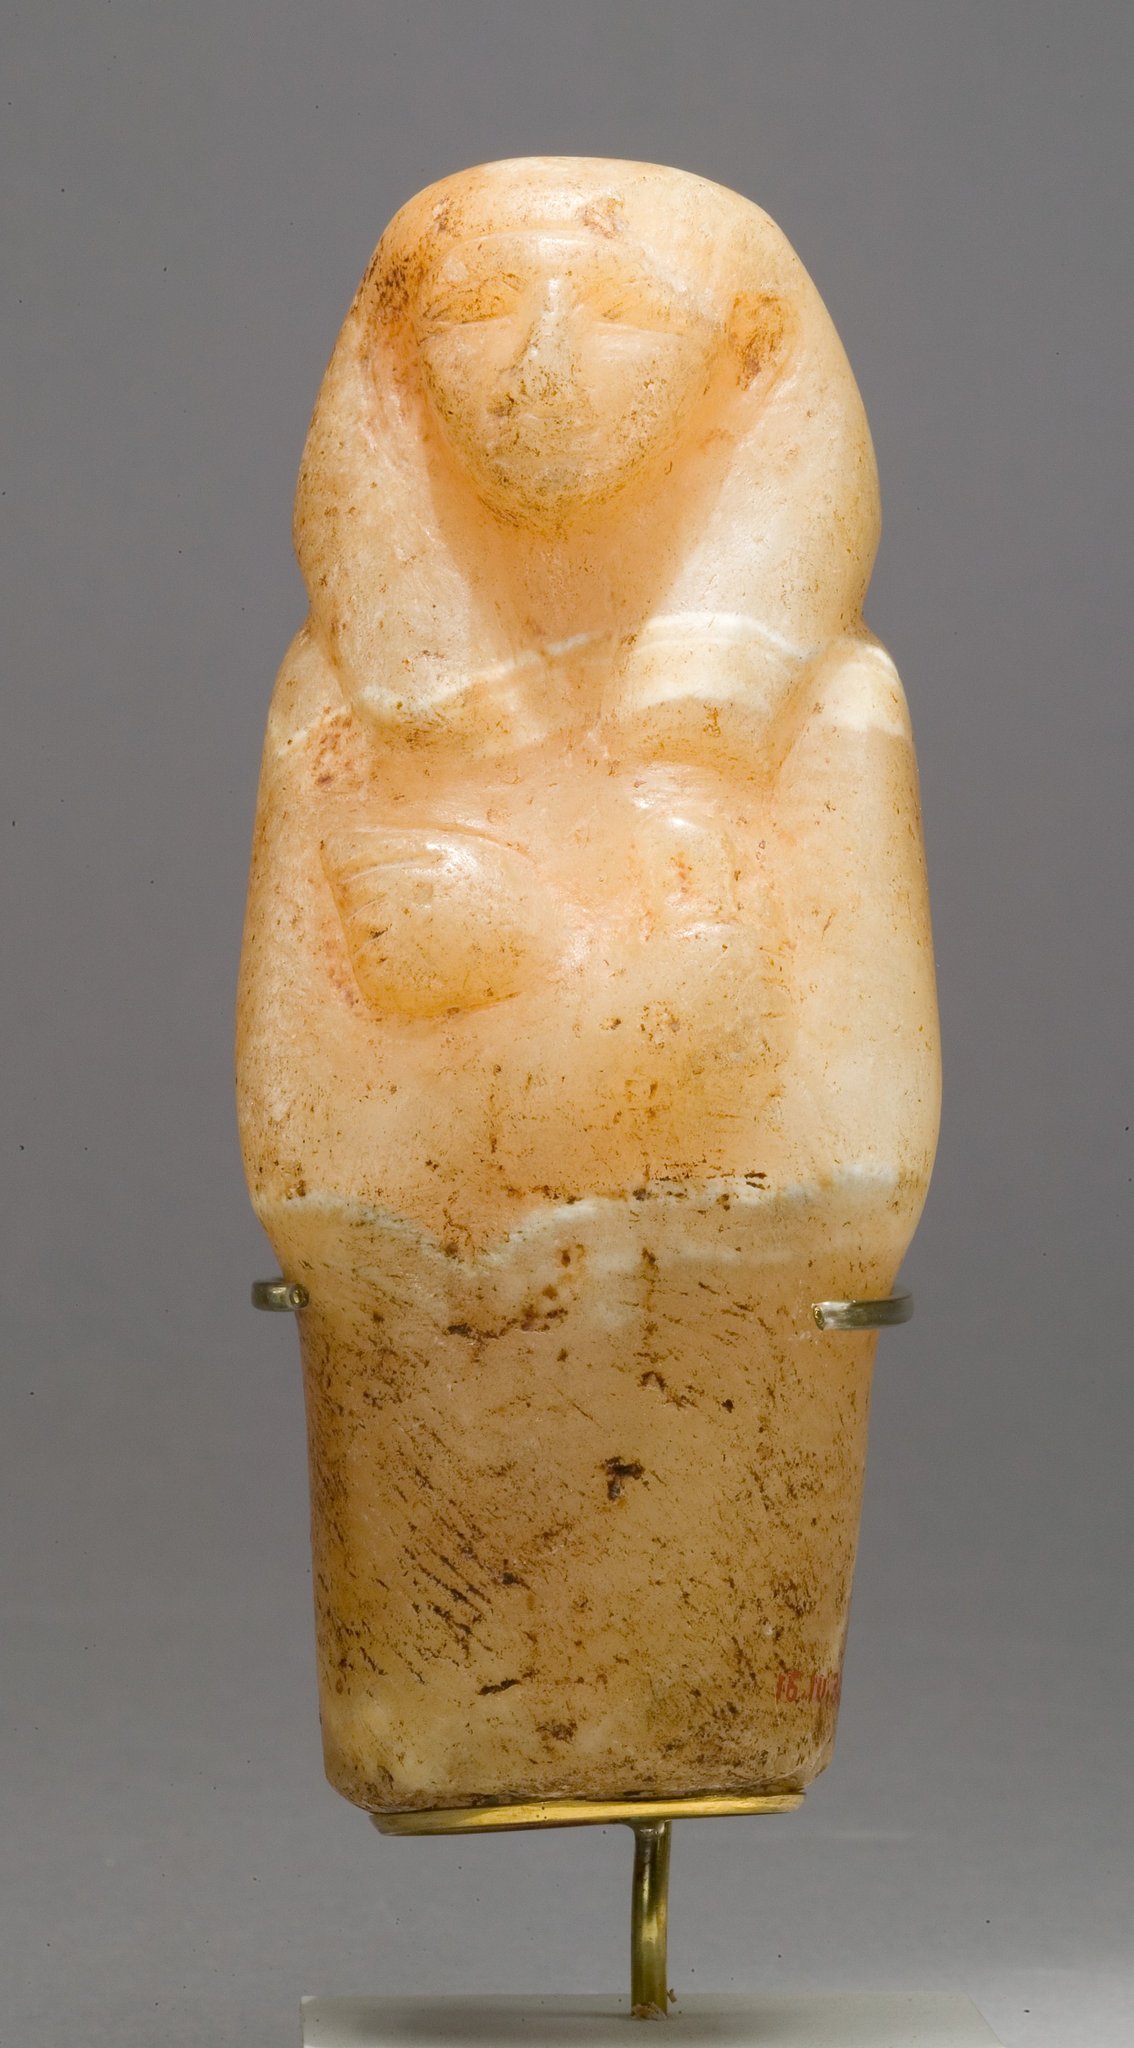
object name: shabti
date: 1635-1458 BCE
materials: stone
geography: egypt